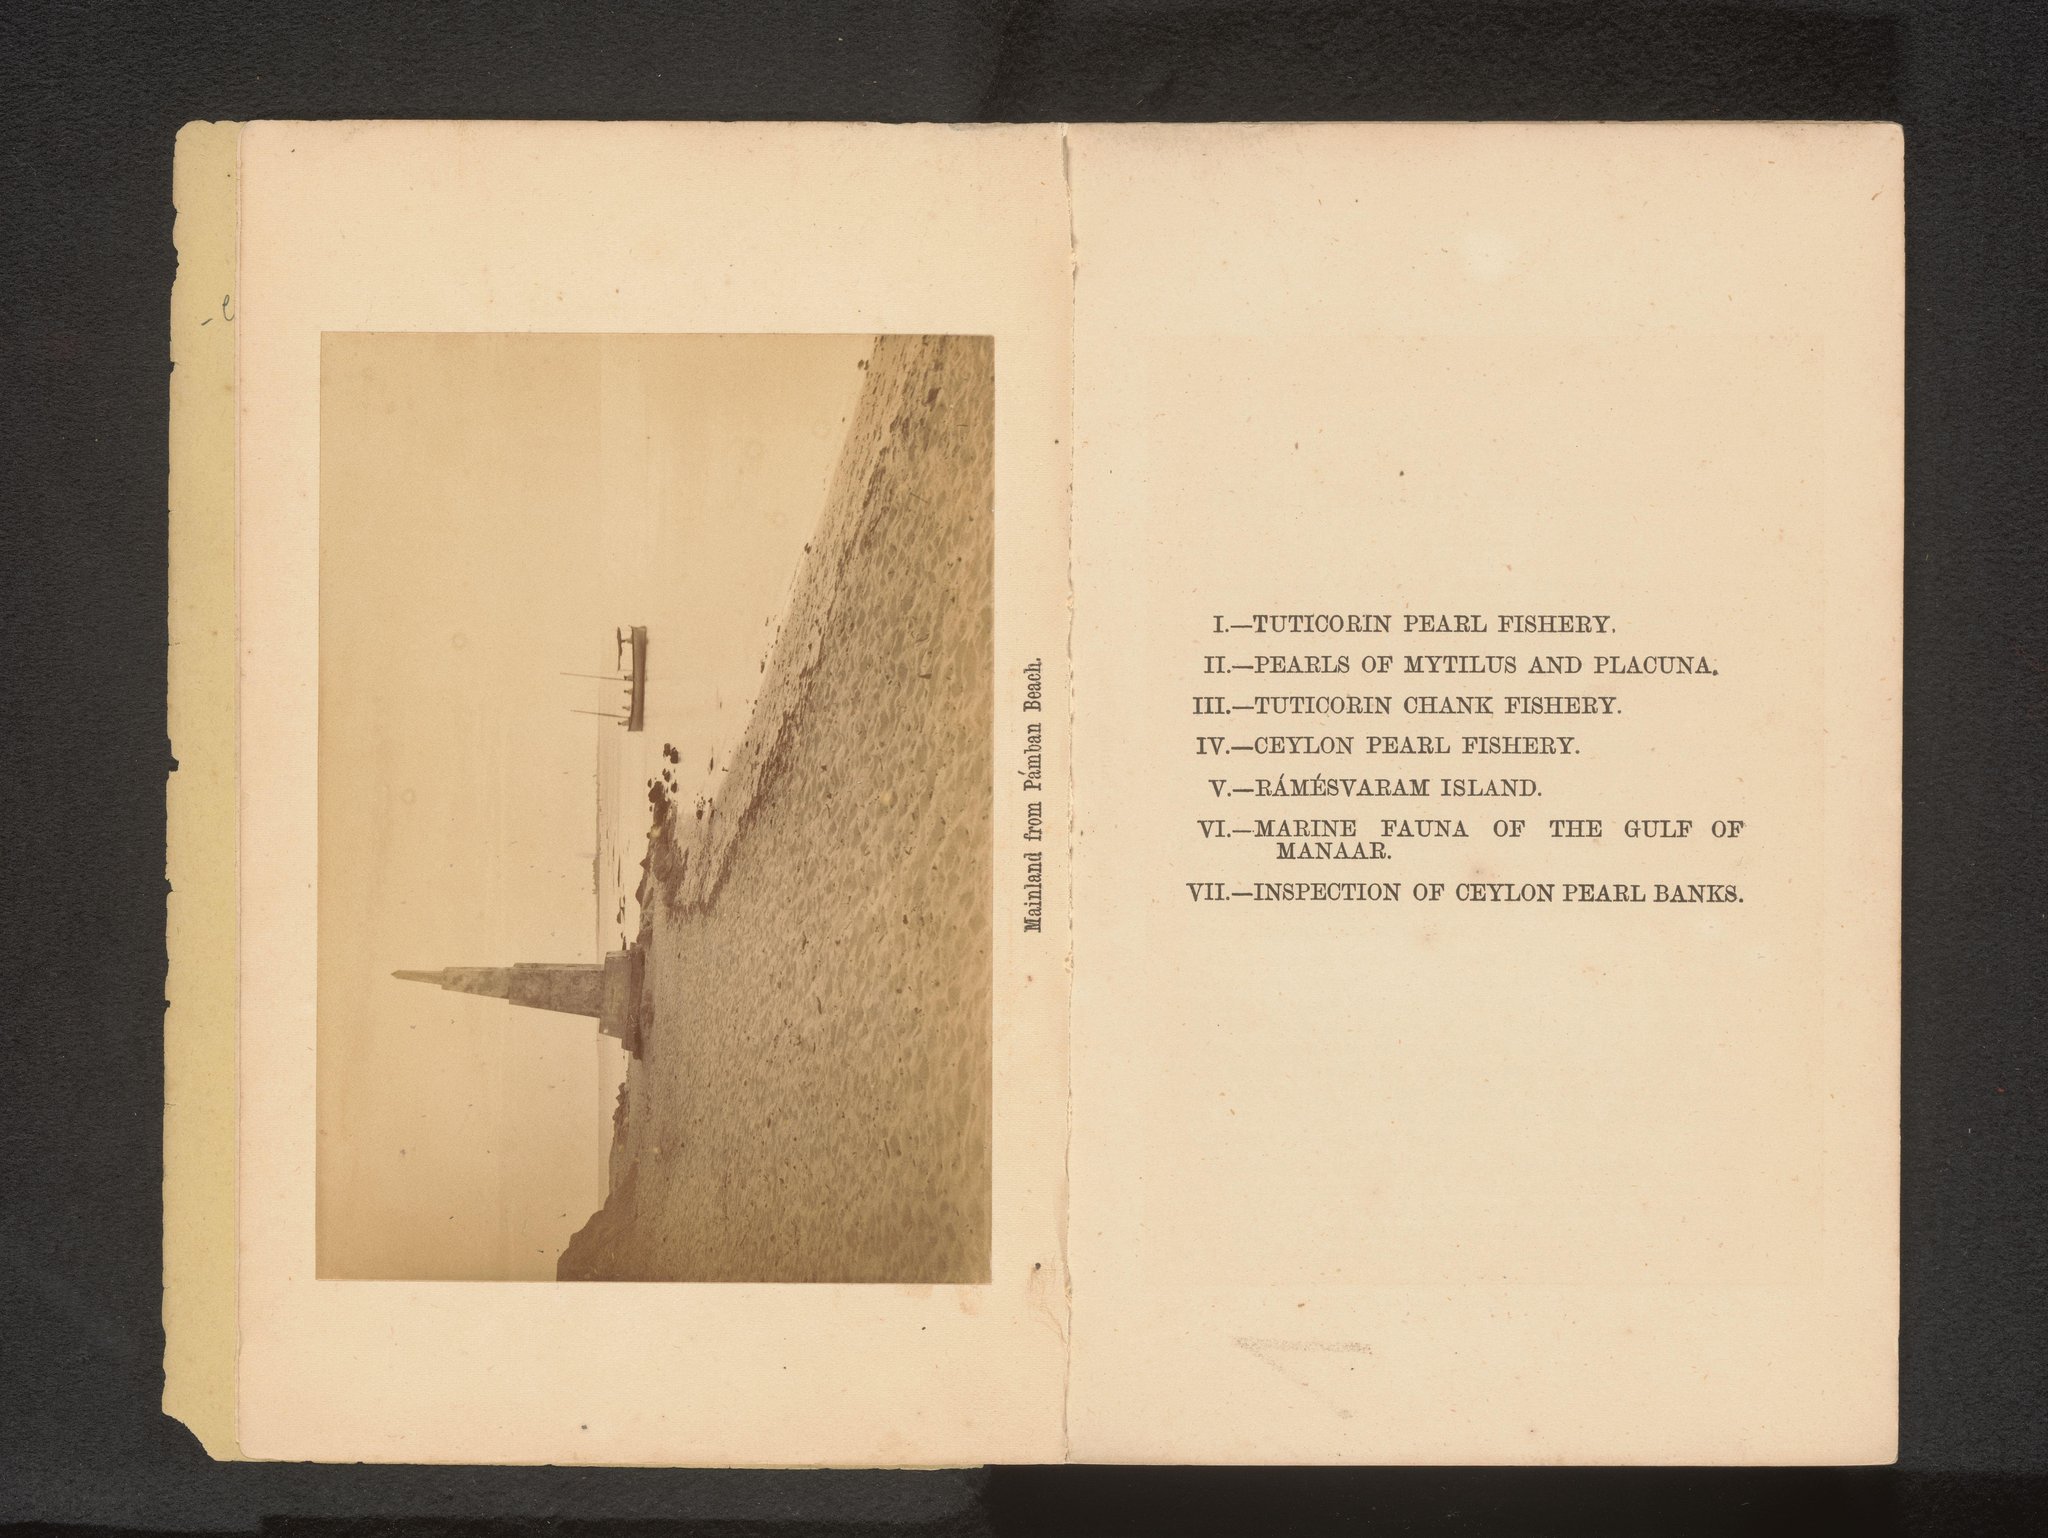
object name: page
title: Mainland from Pámban Beach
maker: Anonymous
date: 1880-1890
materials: photographic support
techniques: albumen print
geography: pamban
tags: island, beach